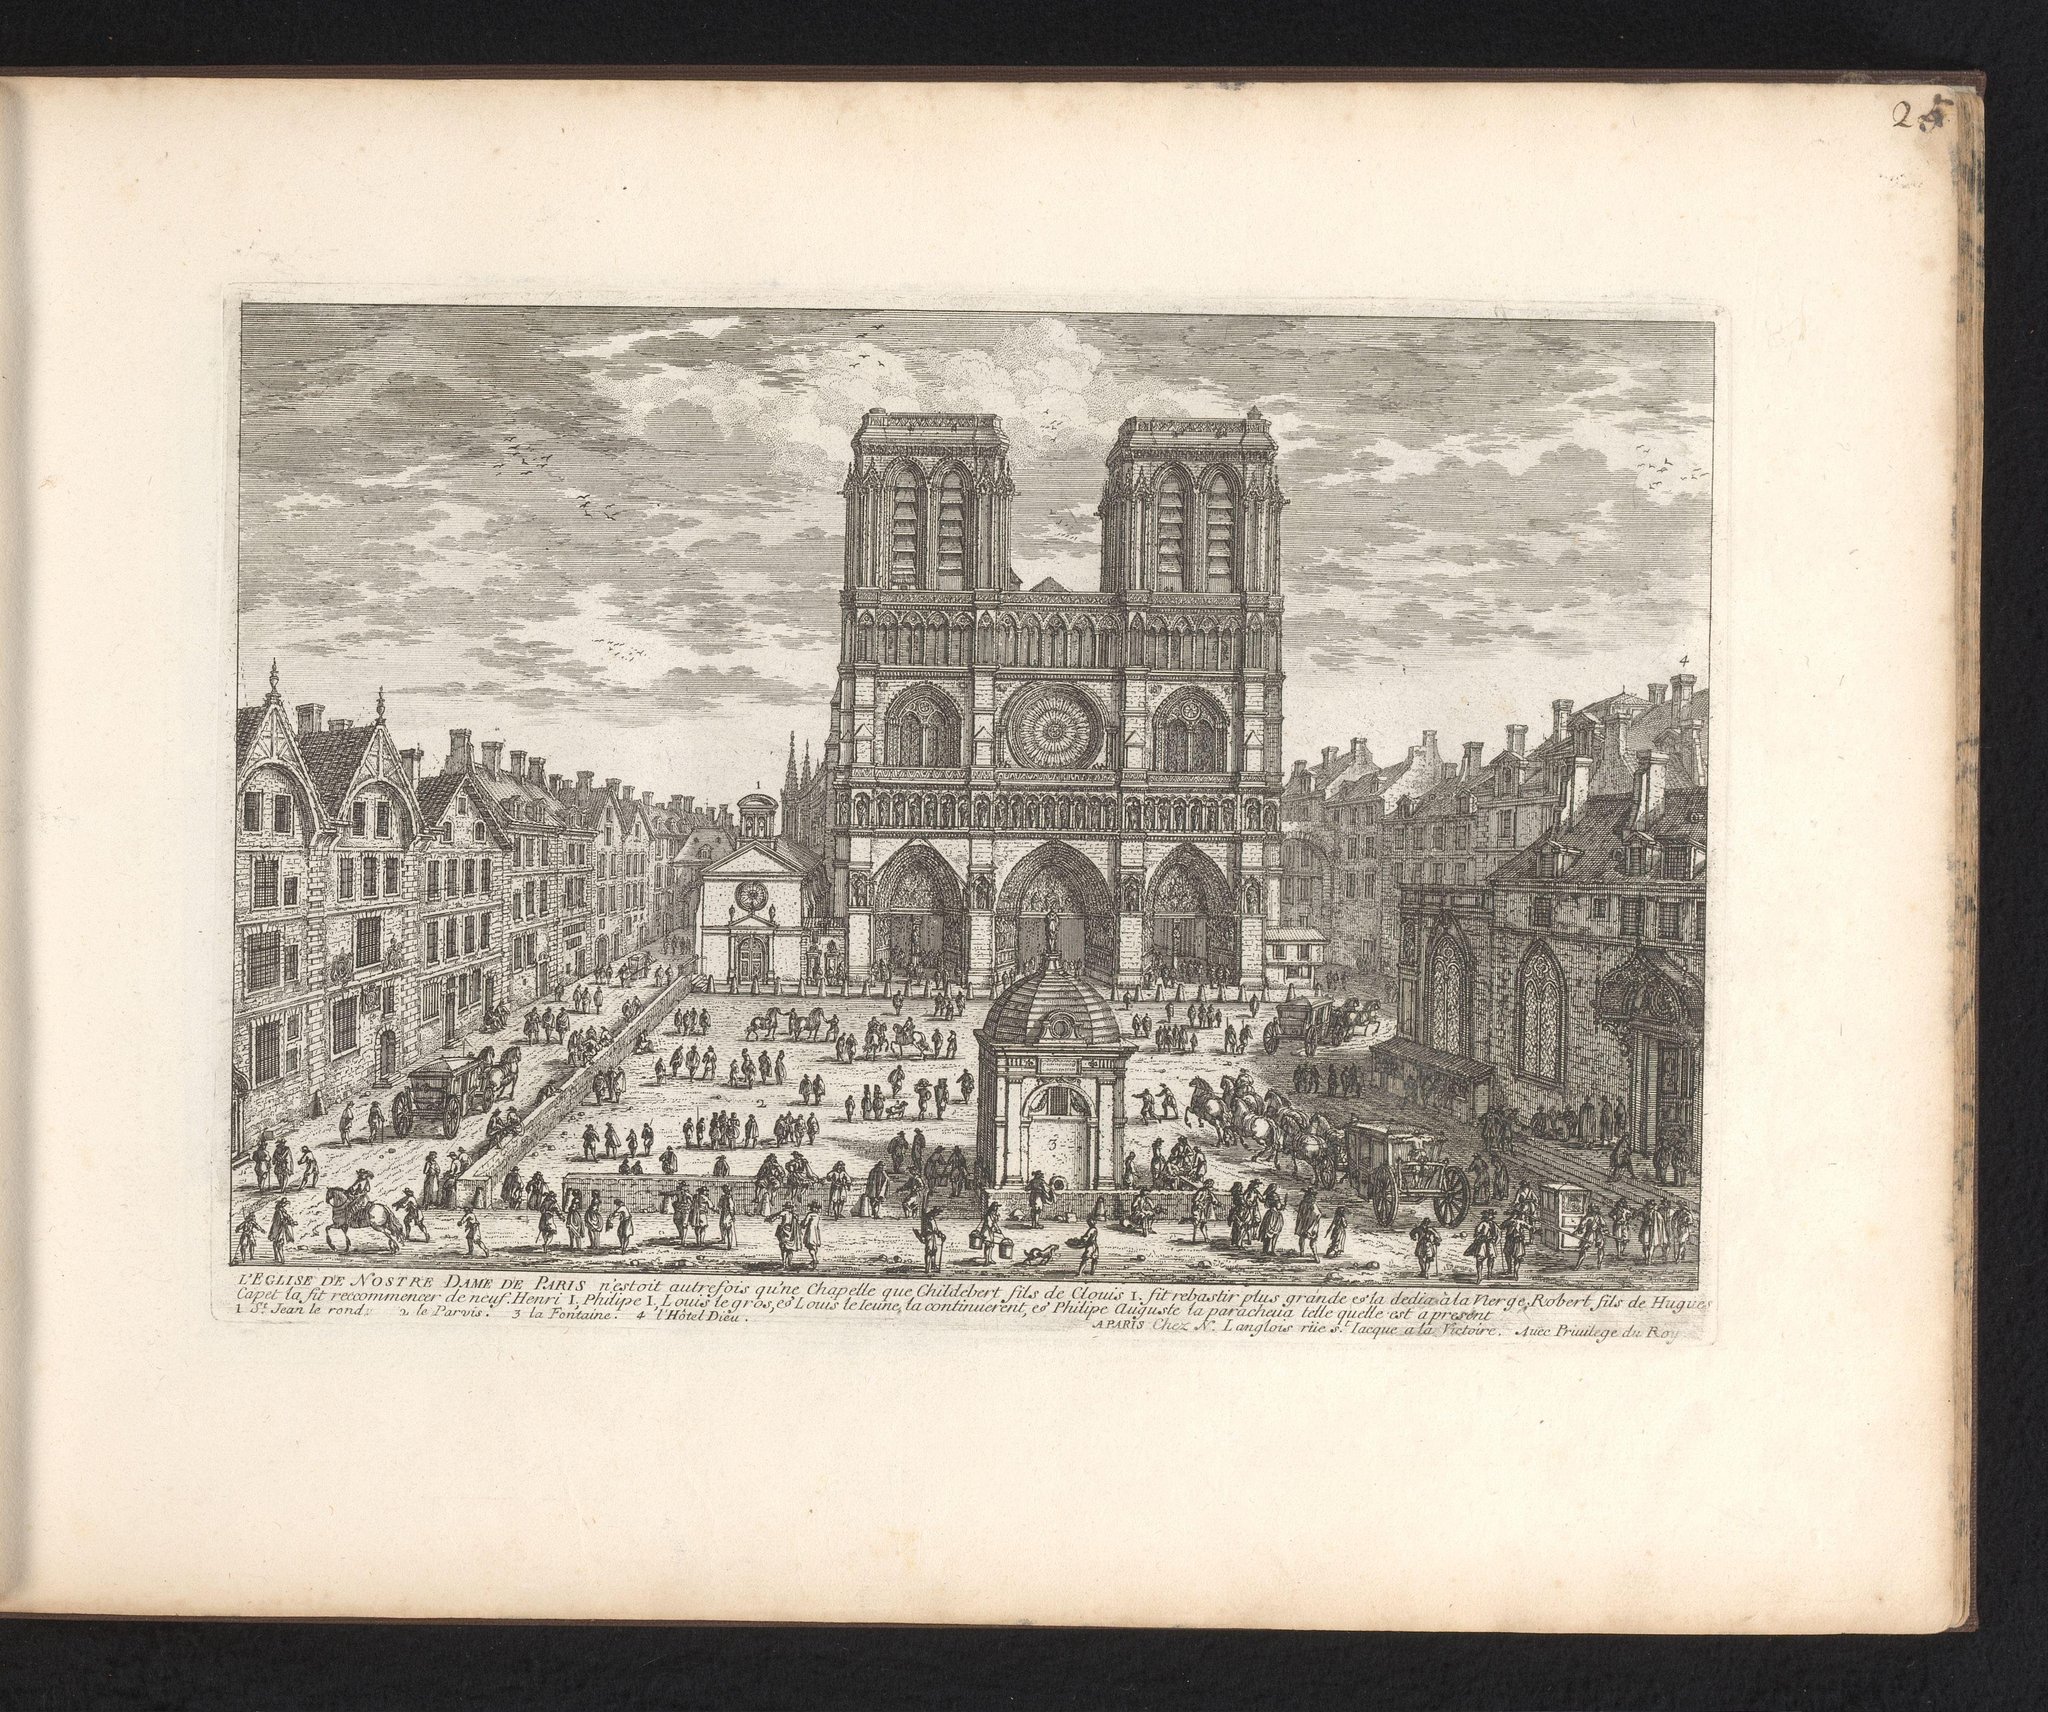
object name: album leaf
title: L'Eglise de Nostre Dame de Paris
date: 1620-1677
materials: paper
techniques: etching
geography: france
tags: city-view in general; 'veduta', church (exterior)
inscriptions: collector's mark: Lugt 2228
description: Prenten met het signatuur 'Perelle' kunnen zowel door vader Gabriel als door zonen Nicolas en Adam gemaakt zijn. De uitgevers vader en zoon Nicolas Langlois worden allebei vermeld als N. Langlois op hetzelfde adres.